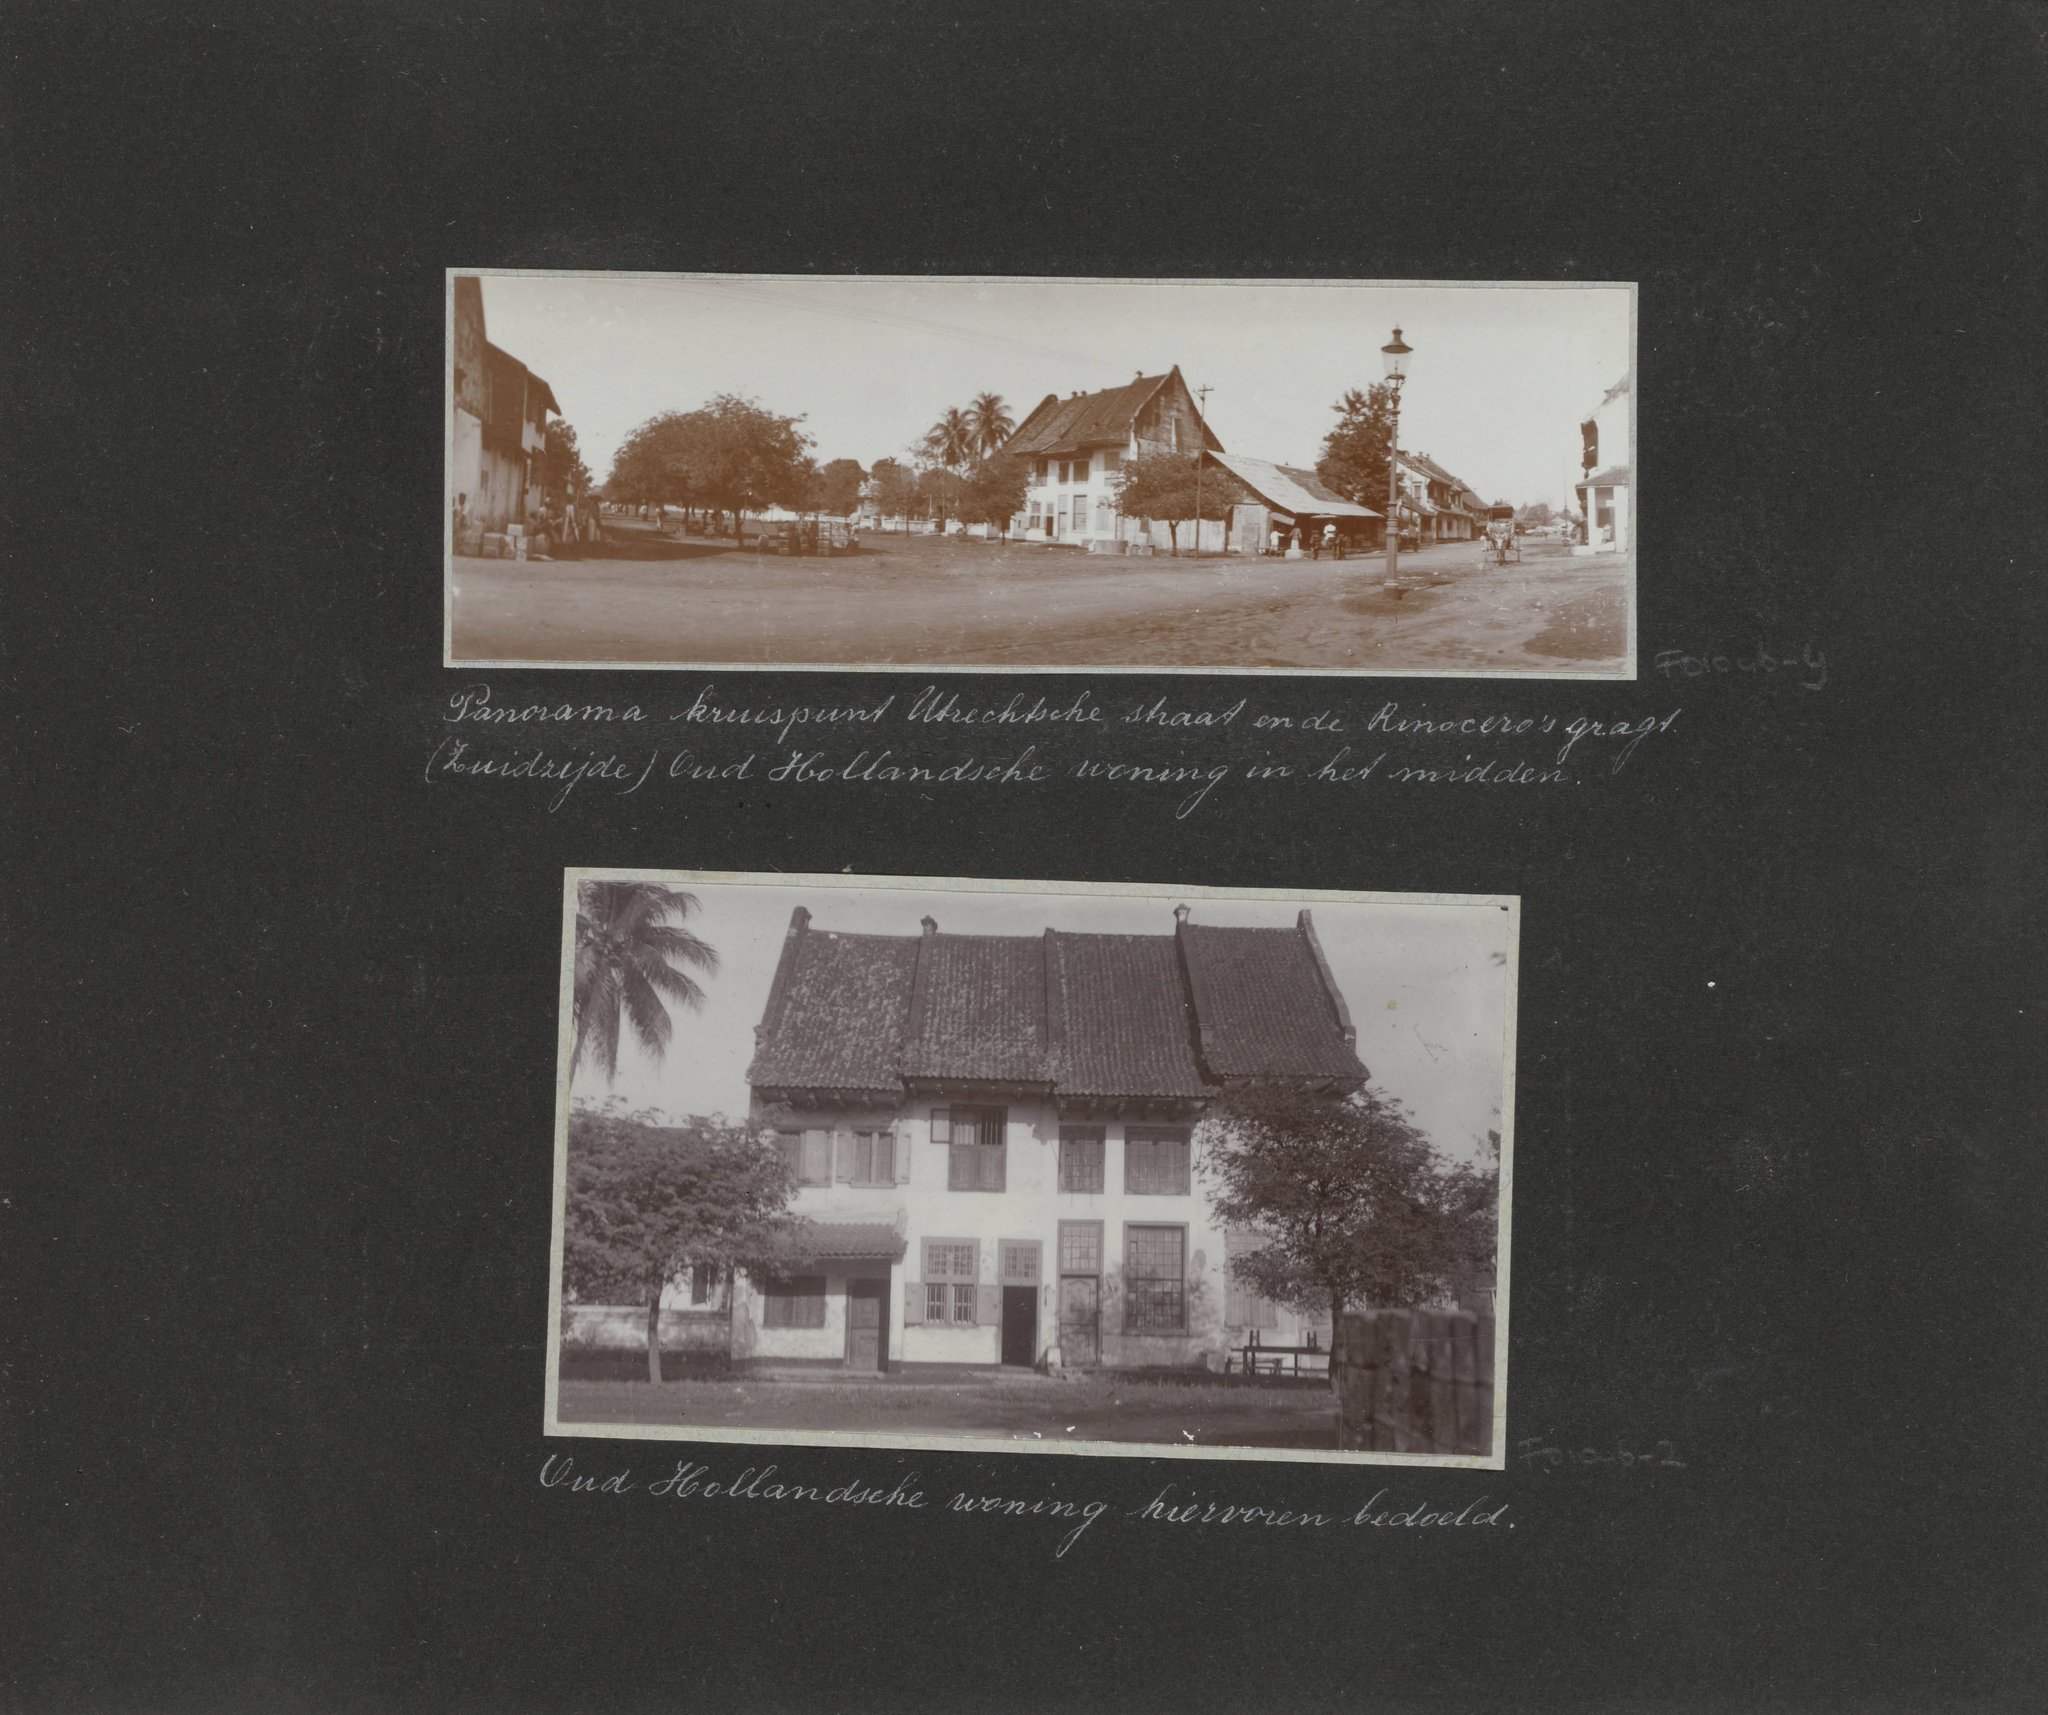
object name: album leaf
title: Exterieur van een oud-Hollandse woning aan het kruispunt van de Utrechtsestraat en Rinocerosgracht (zuidzijde) in Batavia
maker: Anonymous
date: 1920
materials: paper, photographic support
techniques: gelatin silver print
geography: batavia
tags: villa, prospect of city, town panorama, silhouette of city, dutch east indies, the, batavia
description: Onderdeel van Reisalbum met foto's van Batavia.